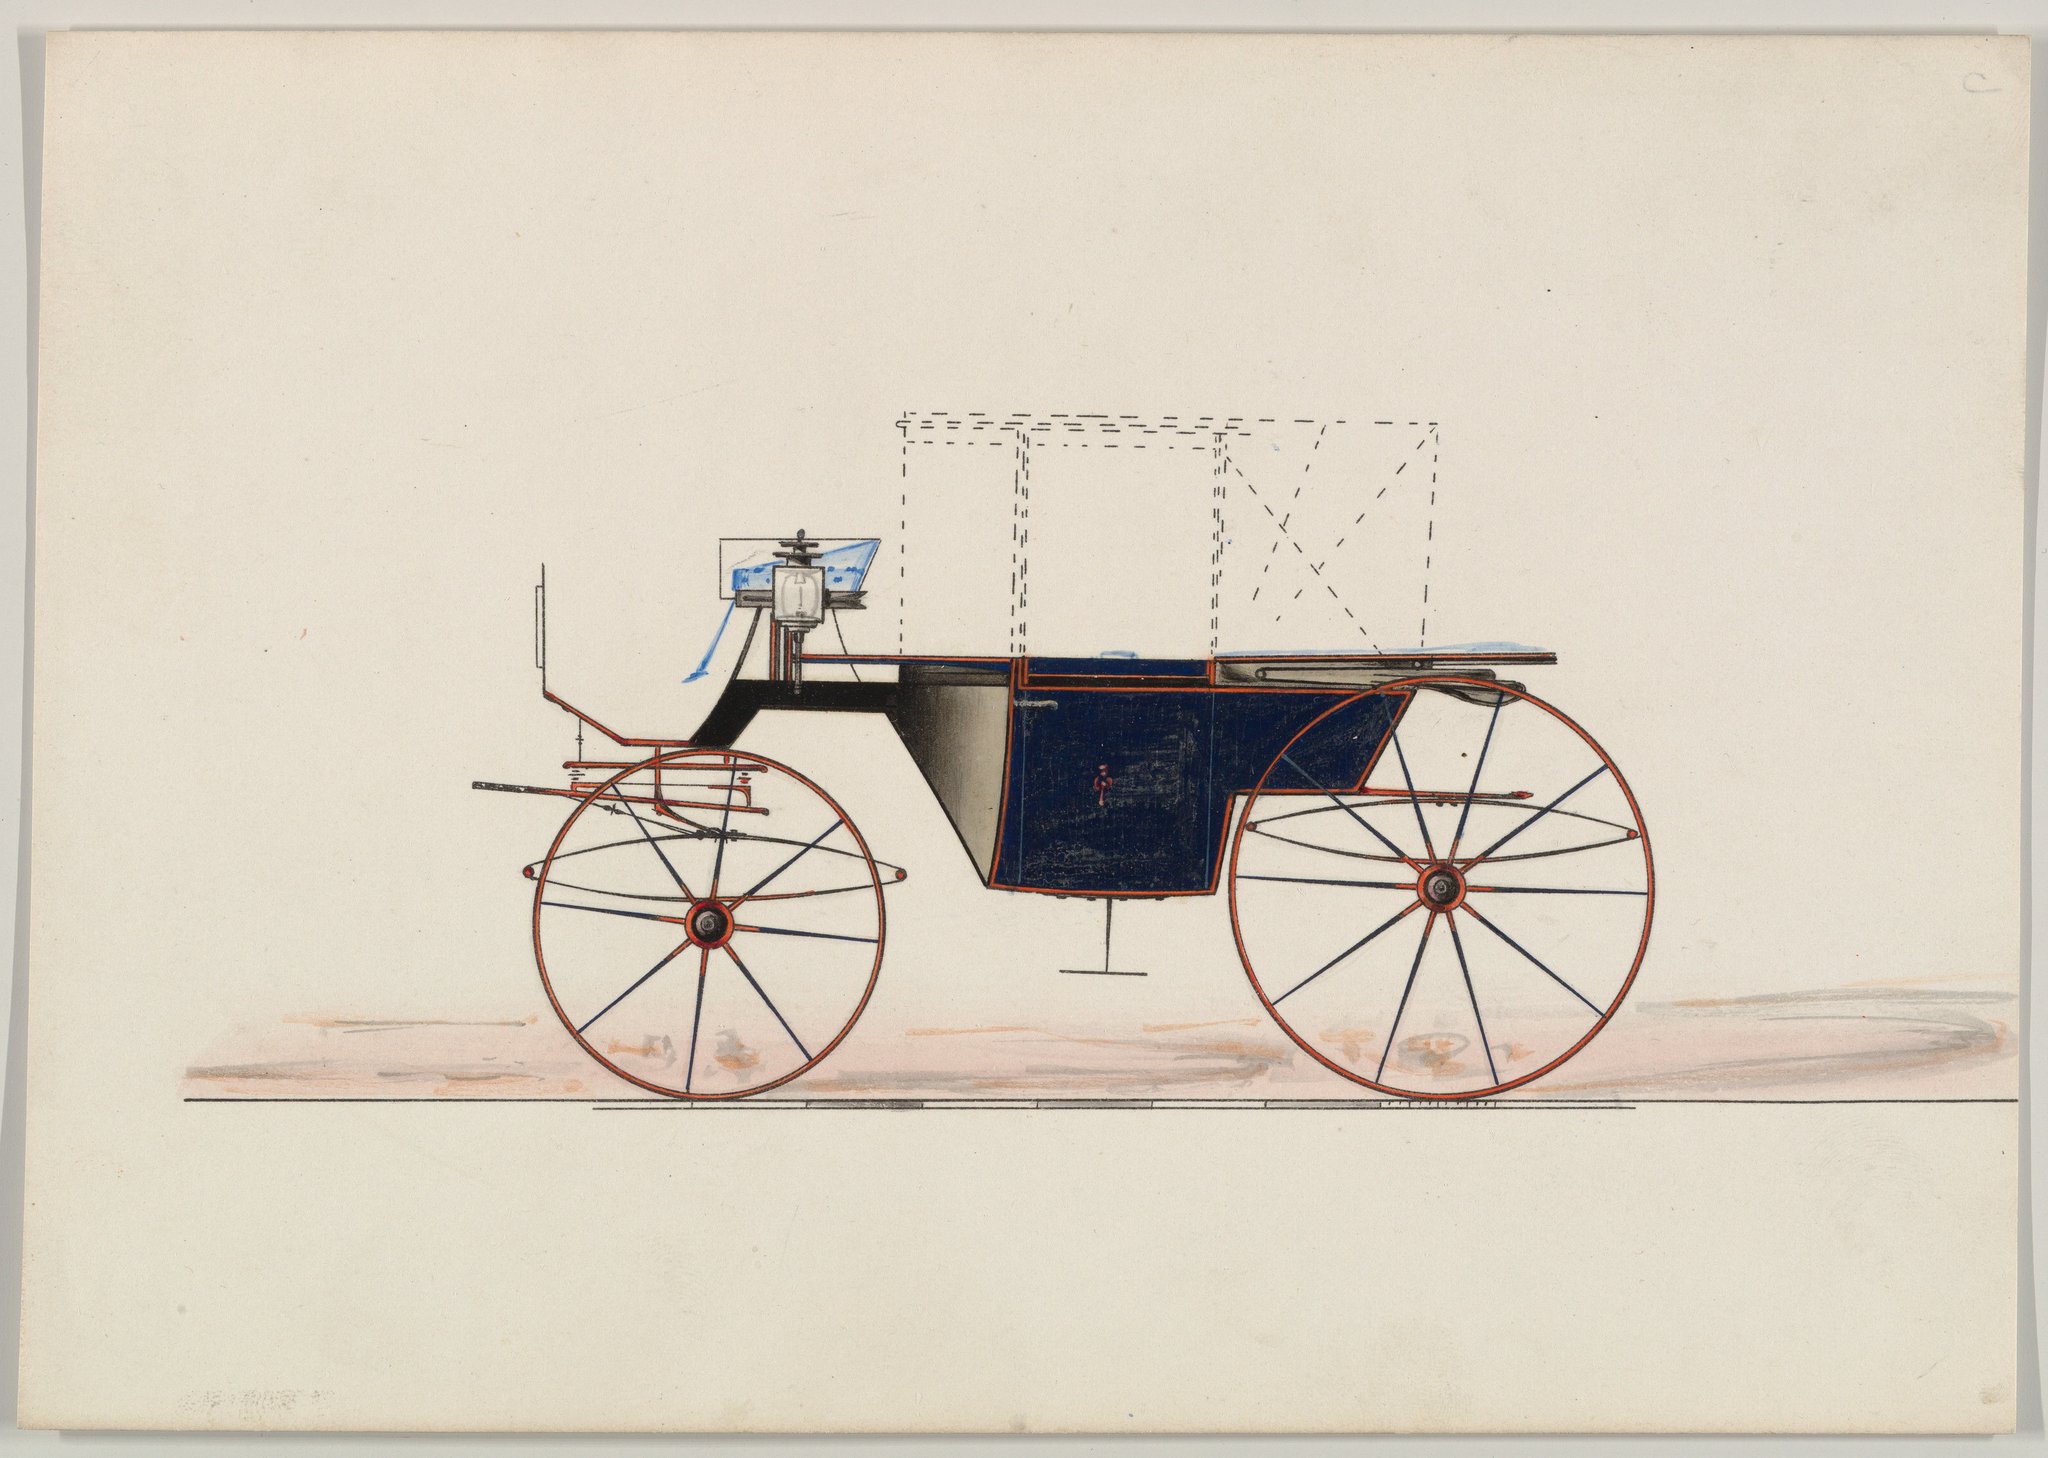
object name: drawing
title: Landaulet (unnumbered)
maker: brewster & co.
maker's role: manufacturer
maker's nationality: american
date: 1850-1870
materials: gouache, gum arabic, ink, watercolor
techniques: pen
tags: carriages